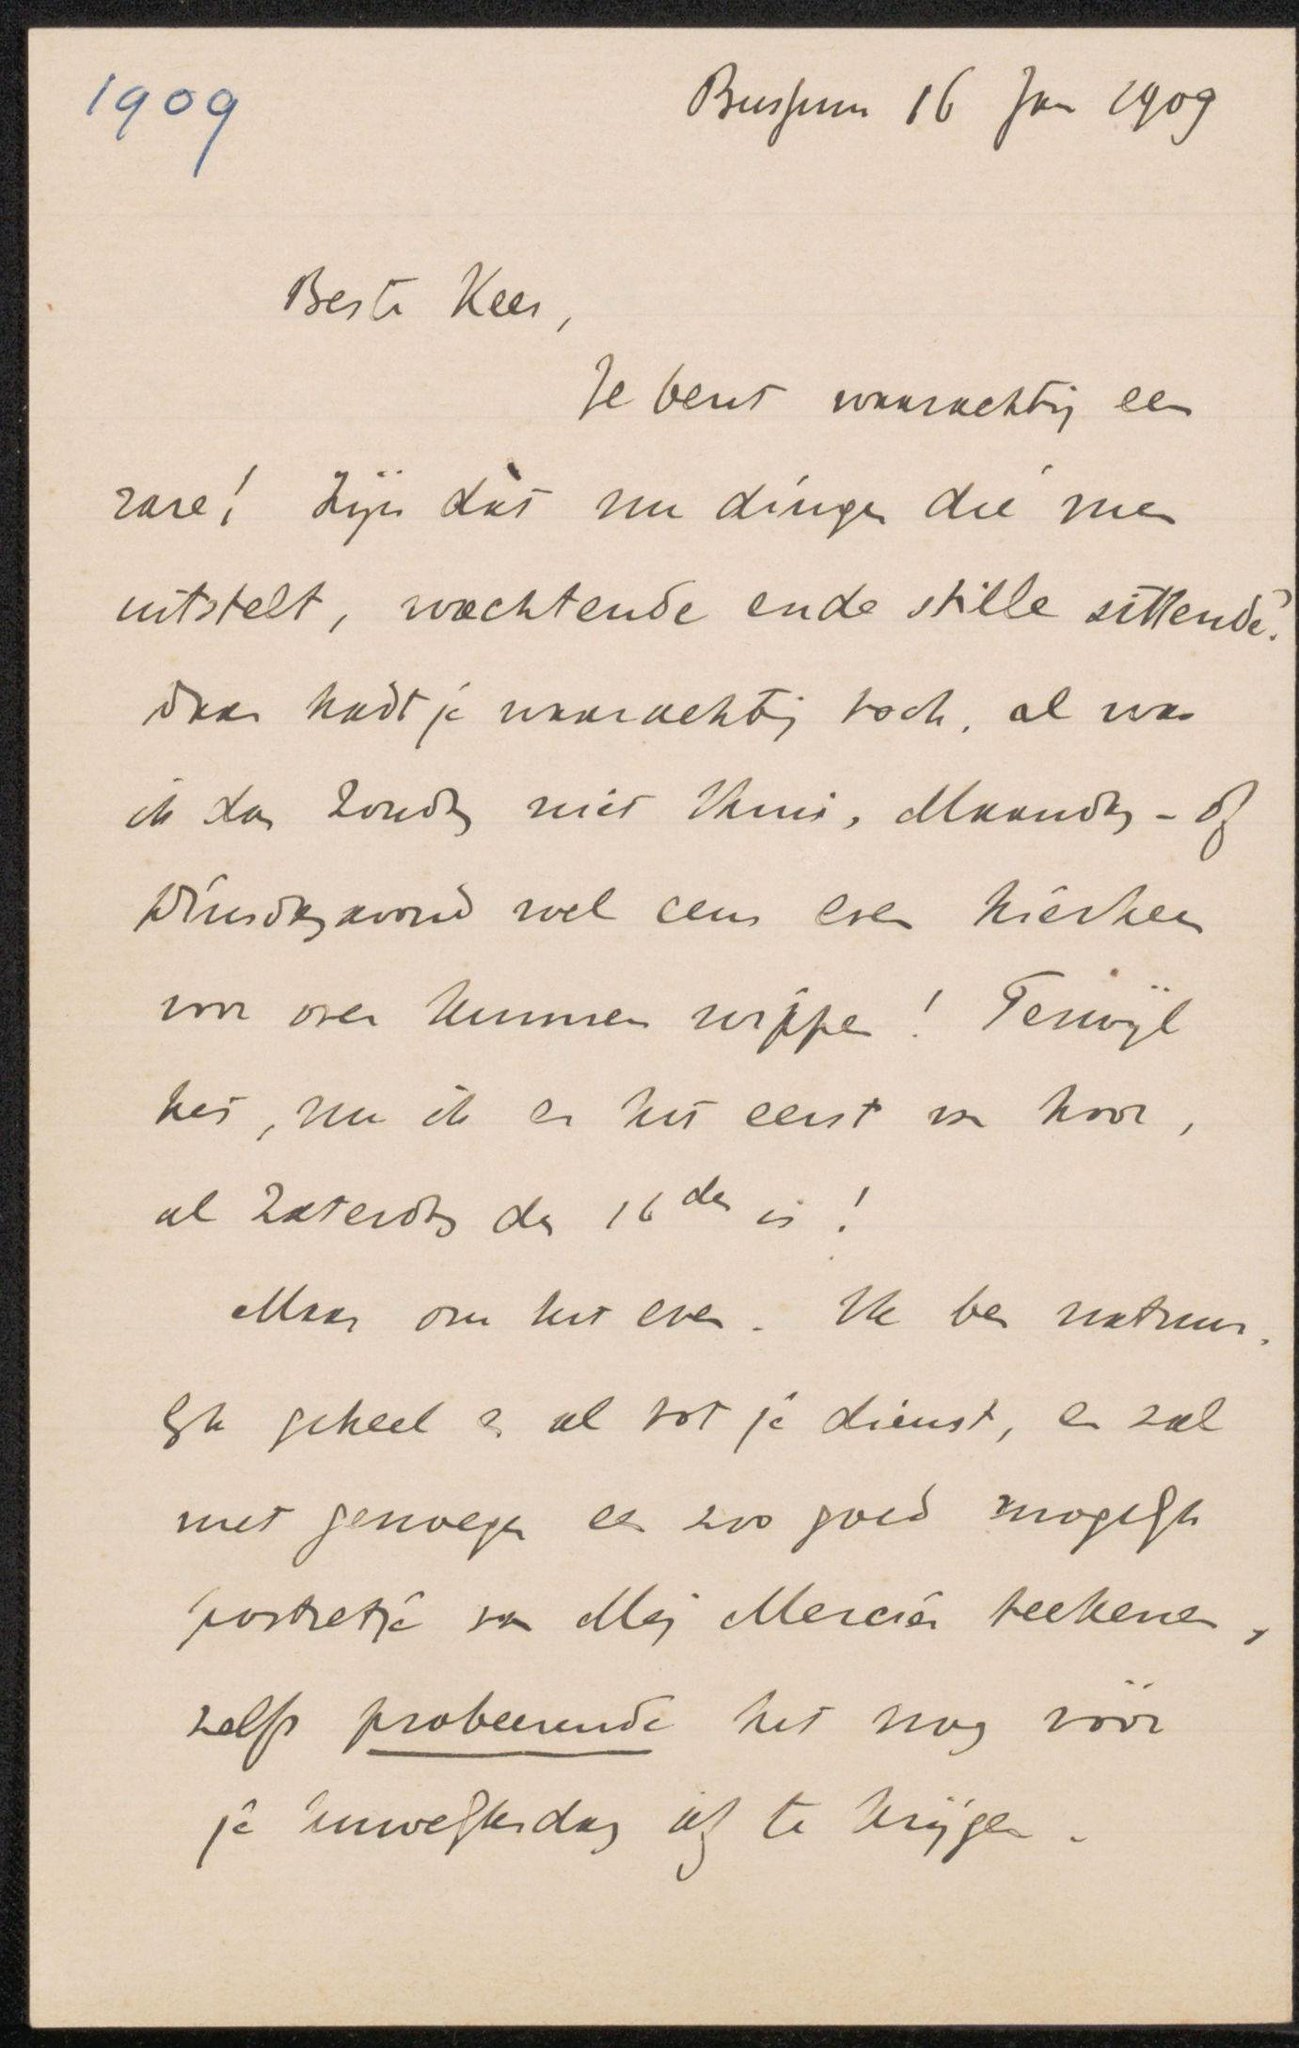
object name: letter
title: Brief aan Cornelis Gerardus 't Hooft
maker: jan veth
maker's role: designer, draughtsman, painter, print maker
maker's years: 1864-1925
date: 1909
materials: ink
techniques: pen, writing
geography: bussum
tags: dordrecht, amsterdam, painter, draughtsman, cornelis gerardus 't hooft, artist's model, sitter, drawing, historical persons (portraits and scenes from the life), money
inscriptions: collector's mark: ‘RPK’, watermark